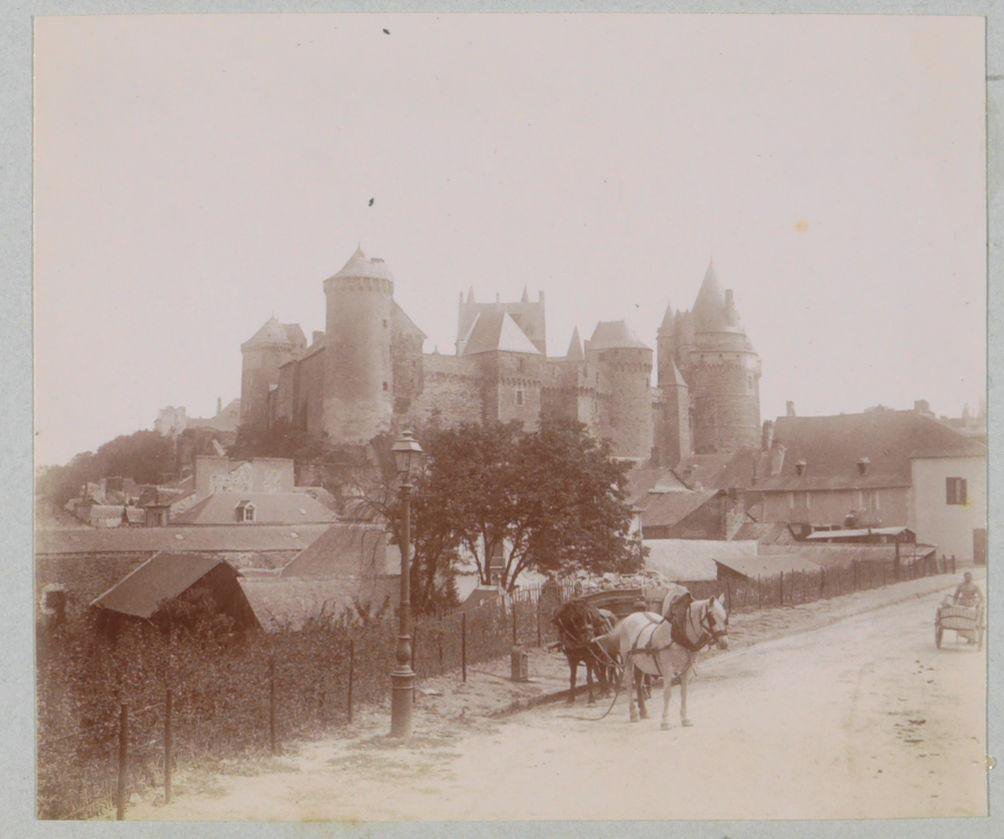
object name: photograph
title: Gezicht op het Kasteel van Vitré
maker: delizy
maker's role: manufacturer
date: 1901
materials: paper, photographic support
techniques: gelatin silver print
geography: josselin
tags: castle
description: Onderdeel van Fotoalbum van een Franse amateurfotograaf met opnames van uitstapjes in Frankrijk, Spanje, België, Luxemburg en Nederland, de eerste automobielen en autoraces.